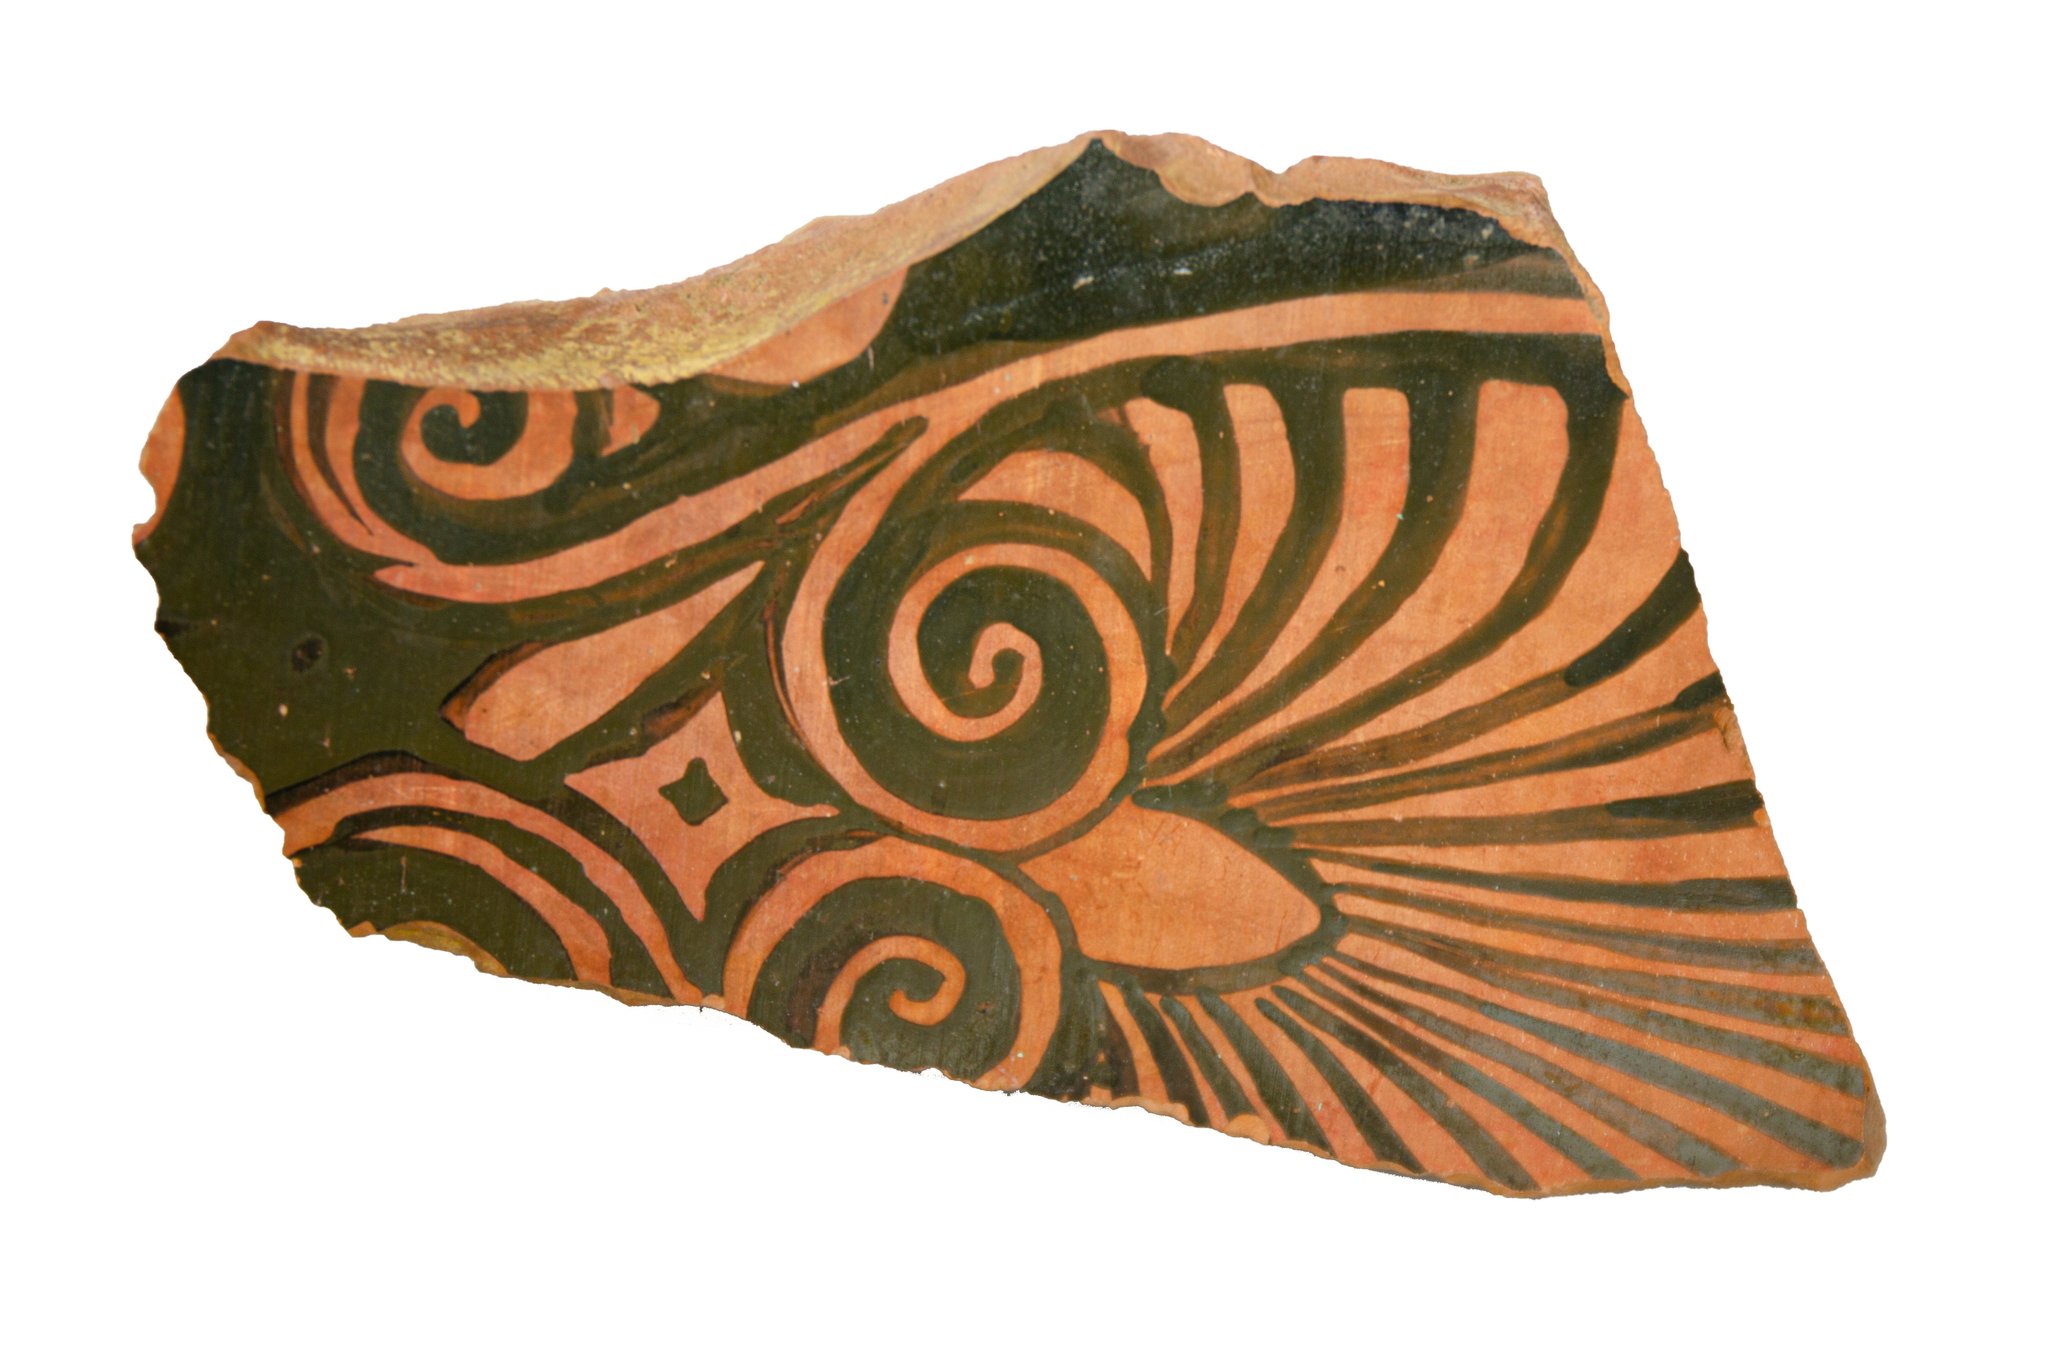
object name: volute krater fragment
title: Volute-krater fragment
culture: greek, south italian, apulian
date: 400-301 BCE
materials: terracotta